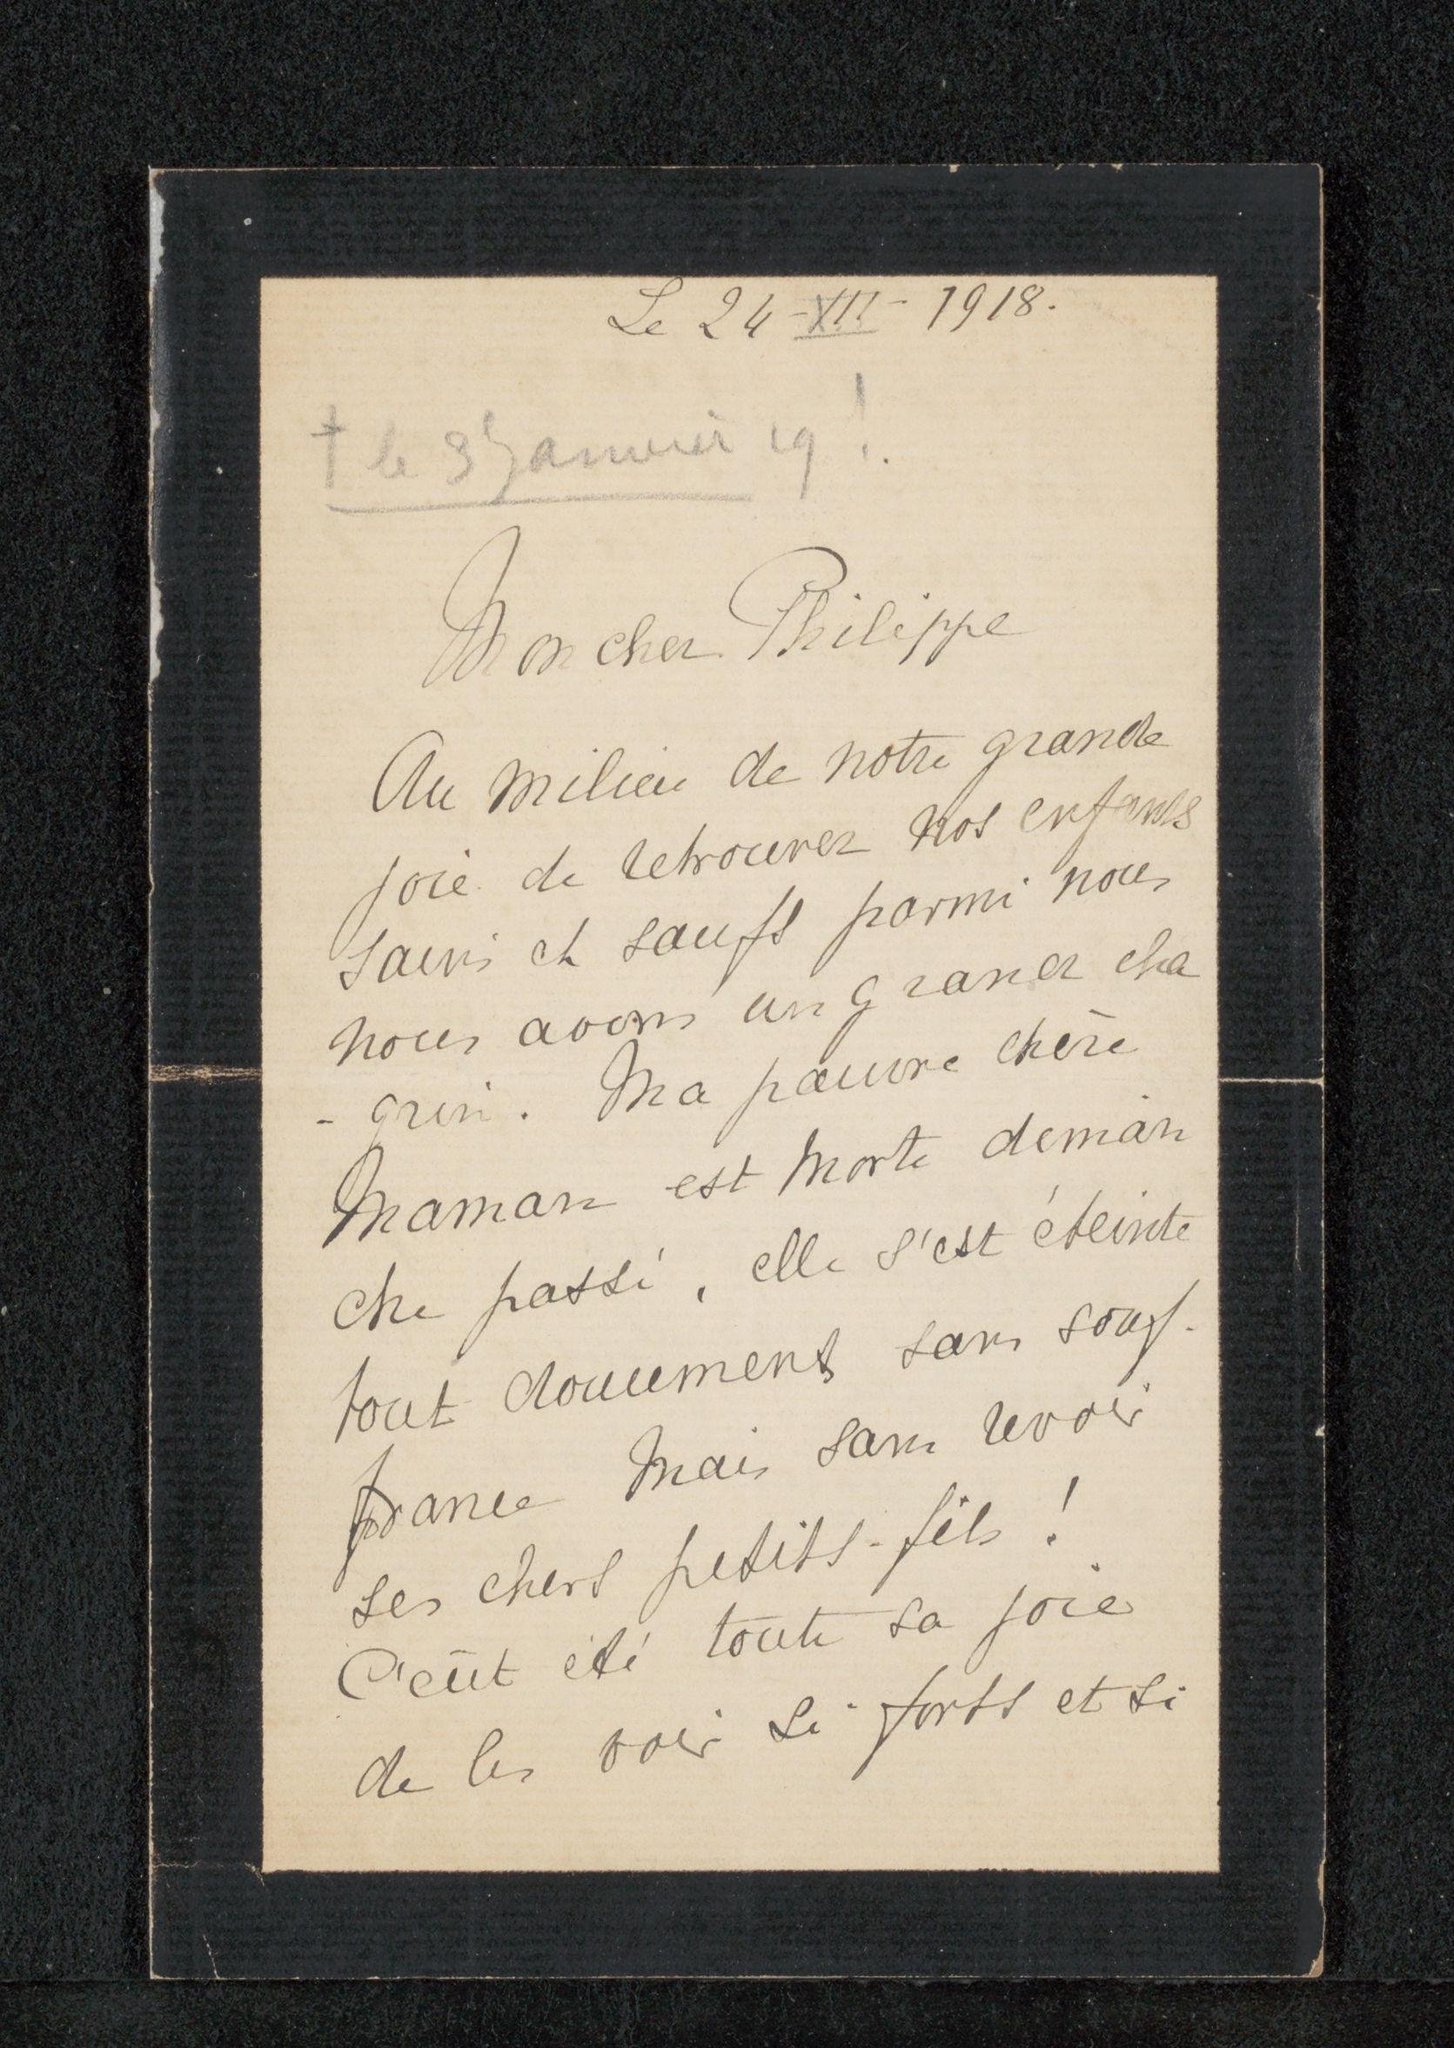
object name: letter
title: Brief aan Philip Zilcken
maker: hélène van goethem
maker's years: 1866-1919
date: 1918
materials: ink, paper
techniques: pen, writing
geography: brussels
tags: draughtsman, philip zilcken, family life, brussels